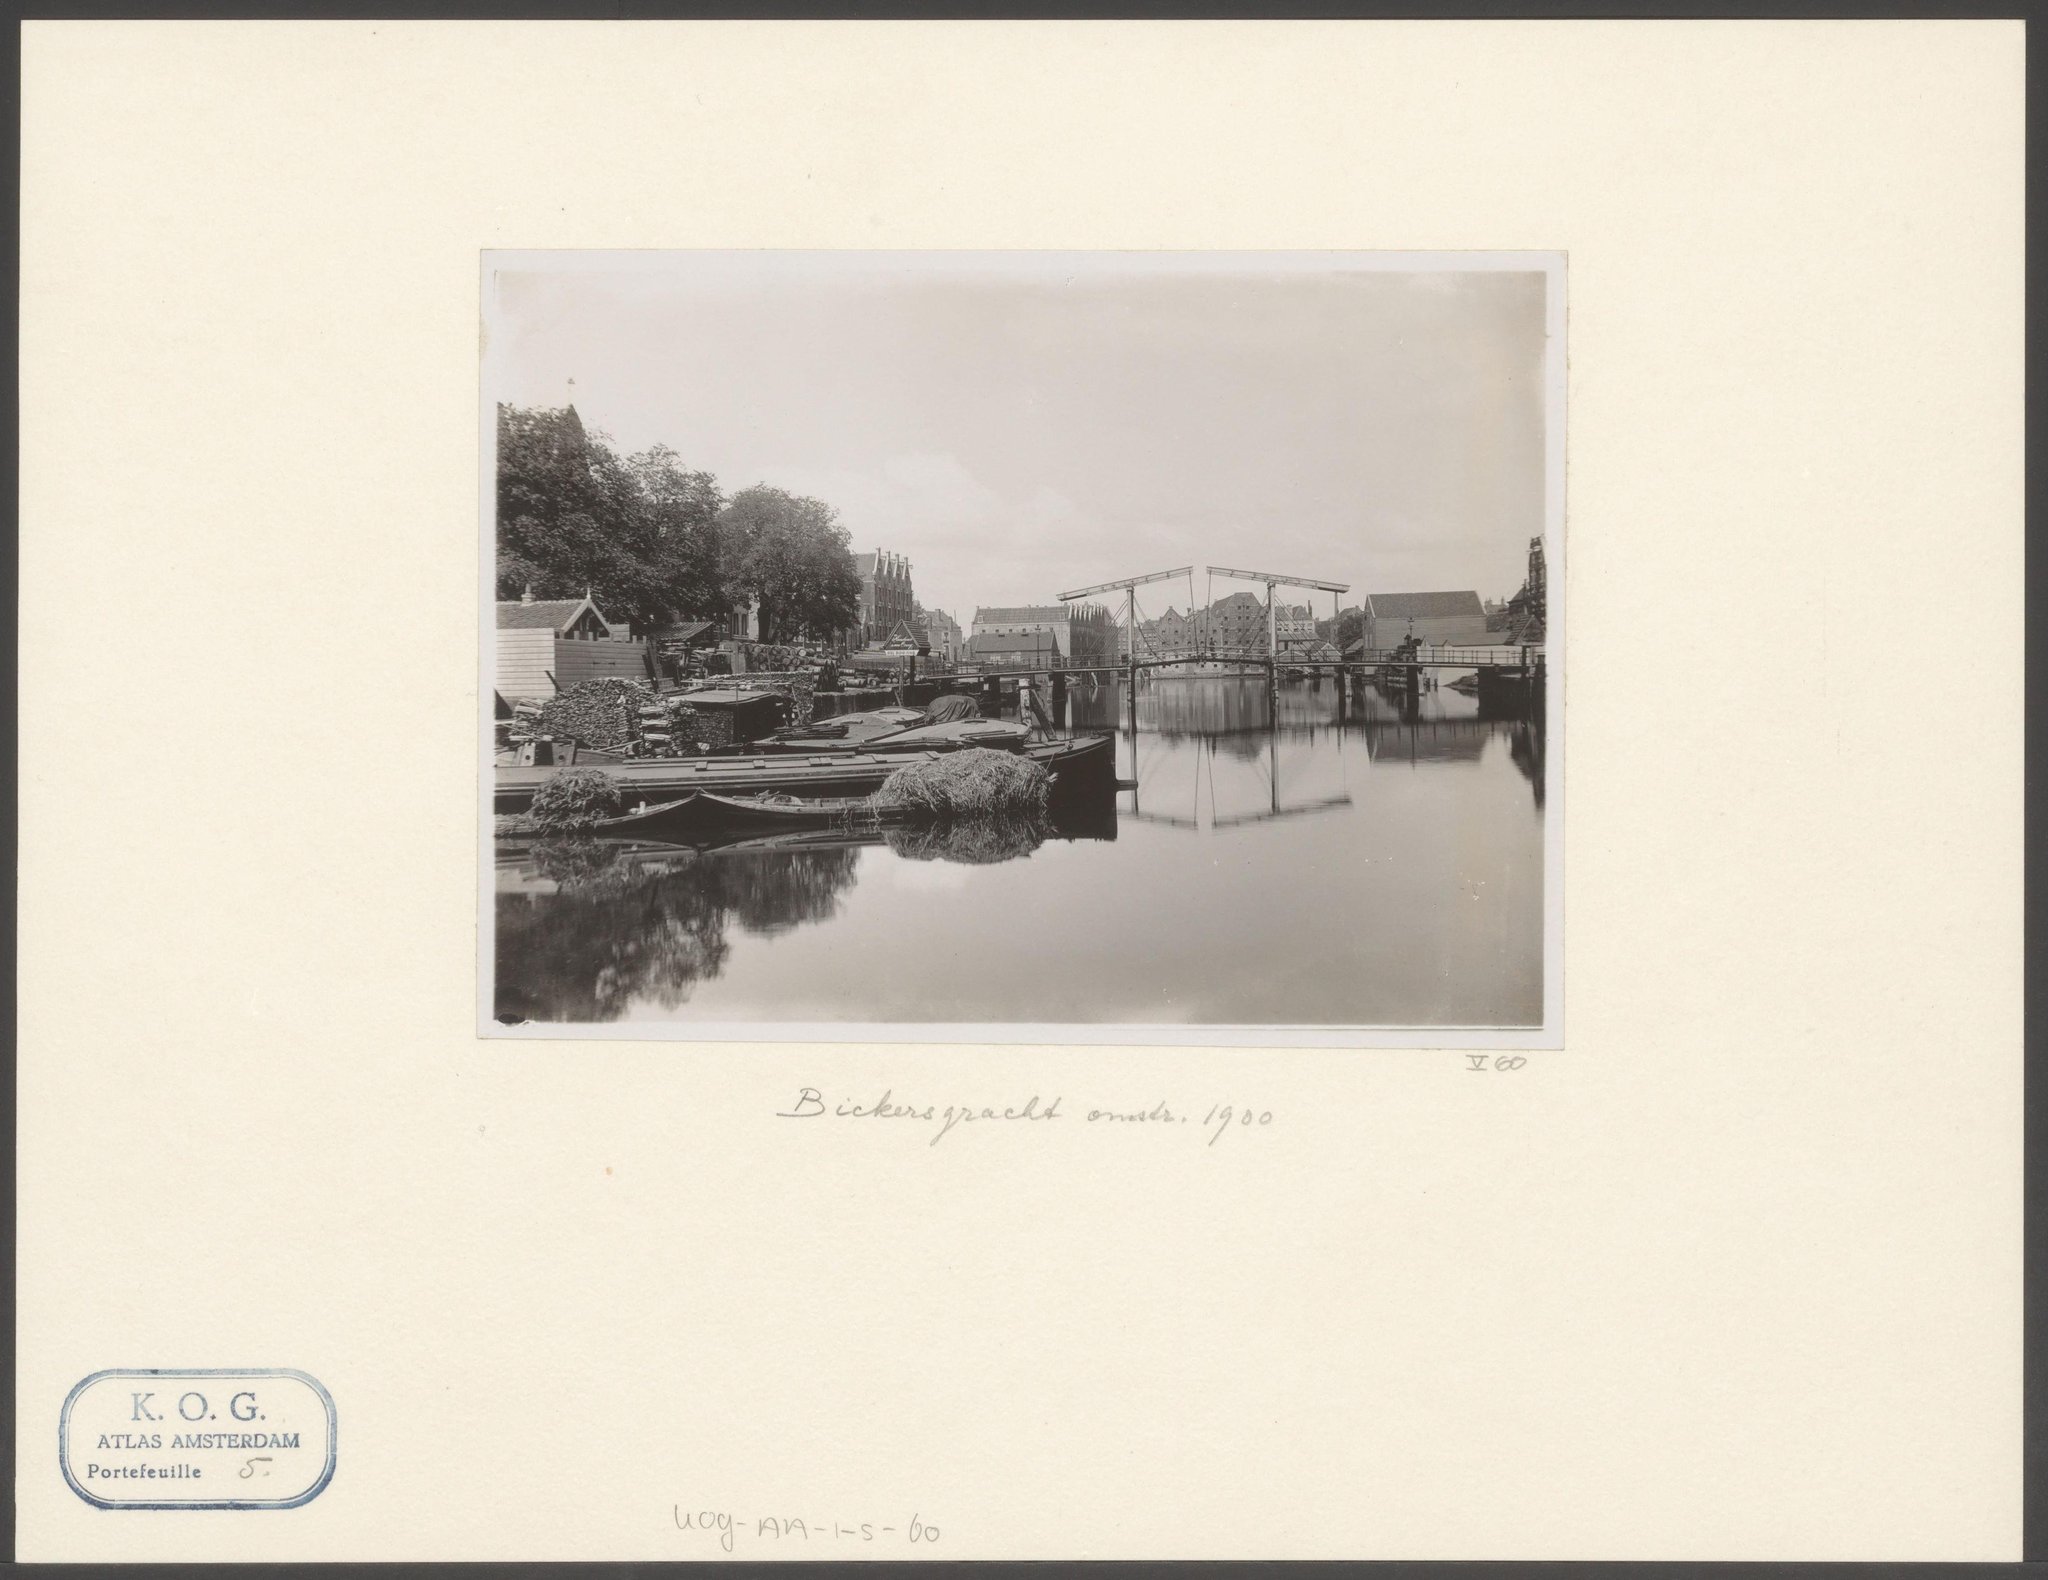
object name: photograph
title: Gezicht op de Prinseneilandgracht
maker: Anonymous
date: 1900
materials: paper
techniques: gelatin silver print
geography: amsterdam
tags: city-view in general; 'veduta', canal, bridge in city across river, canal, etc.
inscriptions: collector's mark: ‘5’ Lugt 1641b, inscription: ‘Bickersgracht omstr. 1900’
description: Op het opzetvel staat beschreven dat dit de Bickersgracht is, maar is dit de Prinseneilandsgracht. Onderwerpsrubriek binnen de Atlas Amsterdam: Begijnensloot (Gedempte), Bagijnhofsteeg, Beulingsloot, Bickersgracht en –plein, Bickersstraat (Groote), Bilderdijkskade en -straat, Binnenkant, Blauwburgwal, Boomdwarsstraat, Brouwersgracht, Bleekersspad (Lange), Bleekerssloot, Bloemgracht, Boerenwetering, Boltensgrachtje, Boomssloot (Recht), Badhuisweg.